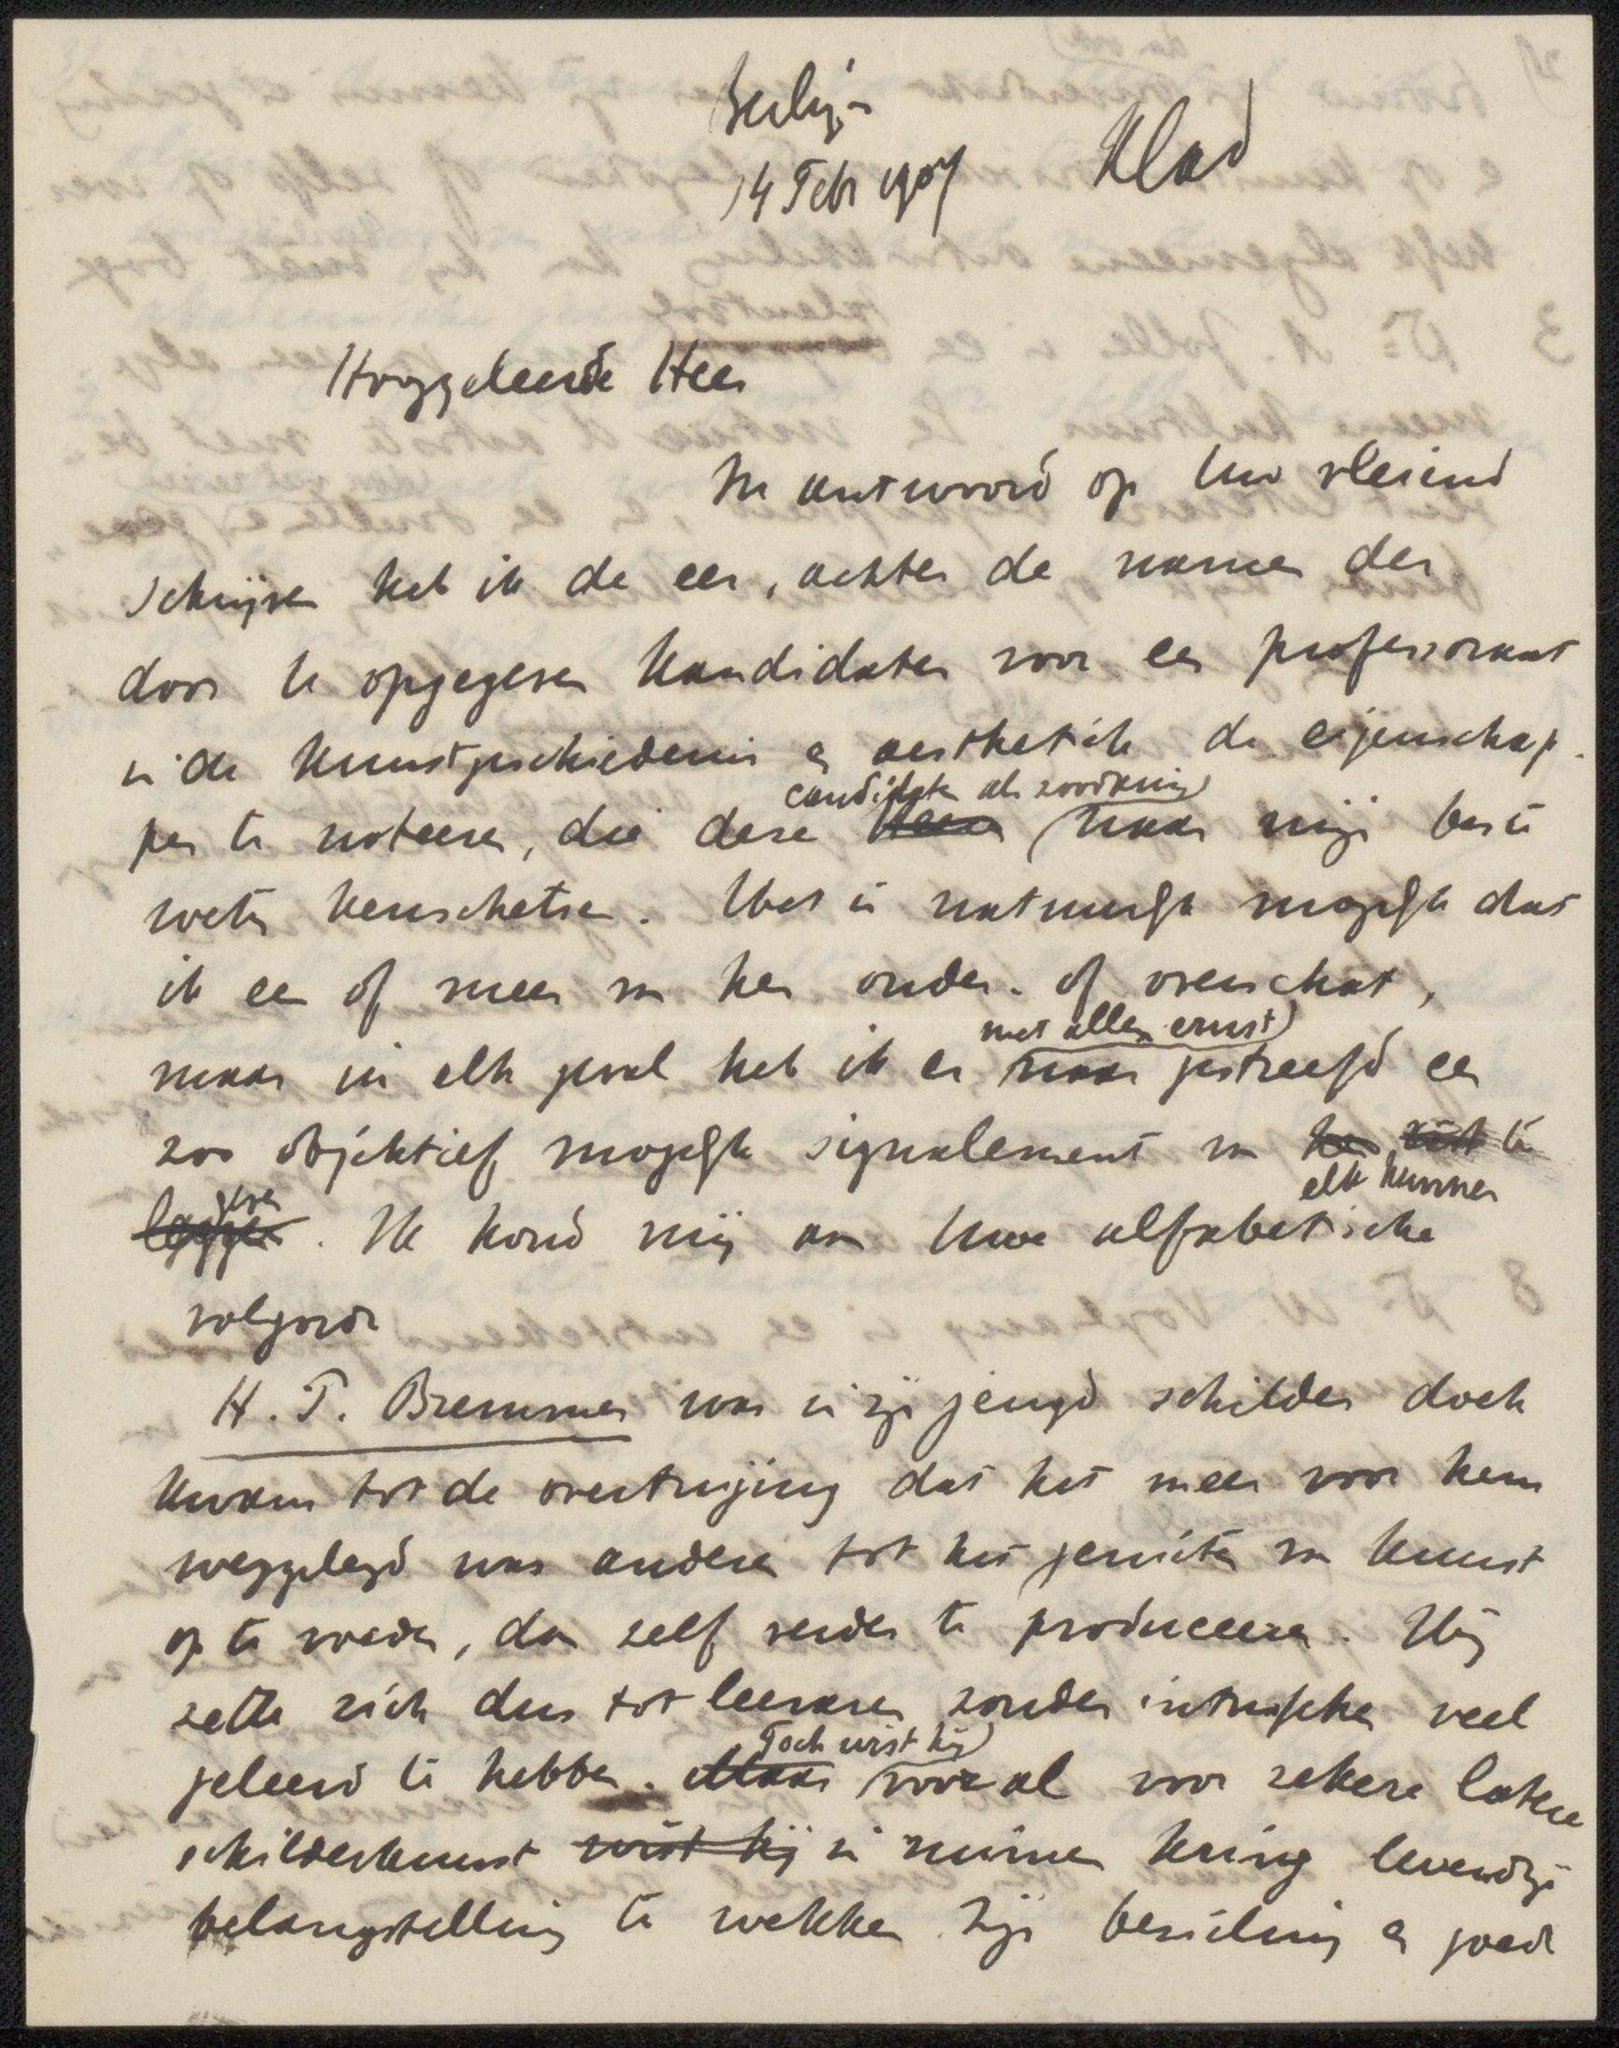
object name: letter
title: Conceptbrief aan Samuel Muller (1848-1922)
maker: jan veth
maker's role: designer, draughtsman, painter, print maker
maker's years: 1864-1925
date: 1907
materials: ink, paper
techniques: pen, writing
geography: berlin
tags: leiden, hendricus petrus bremmer, the hague, nijmegen, adriaan pit, utrecht, willem vogelsang, samuel muller (1848-1922), cornelis hofstede de groot, jan kalff, andré jolles, amsterdam, ernst wilhelm moes, sculpture, painting (including book-illumination, miniature-painting)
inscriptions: collector's mark: ‘RPK’